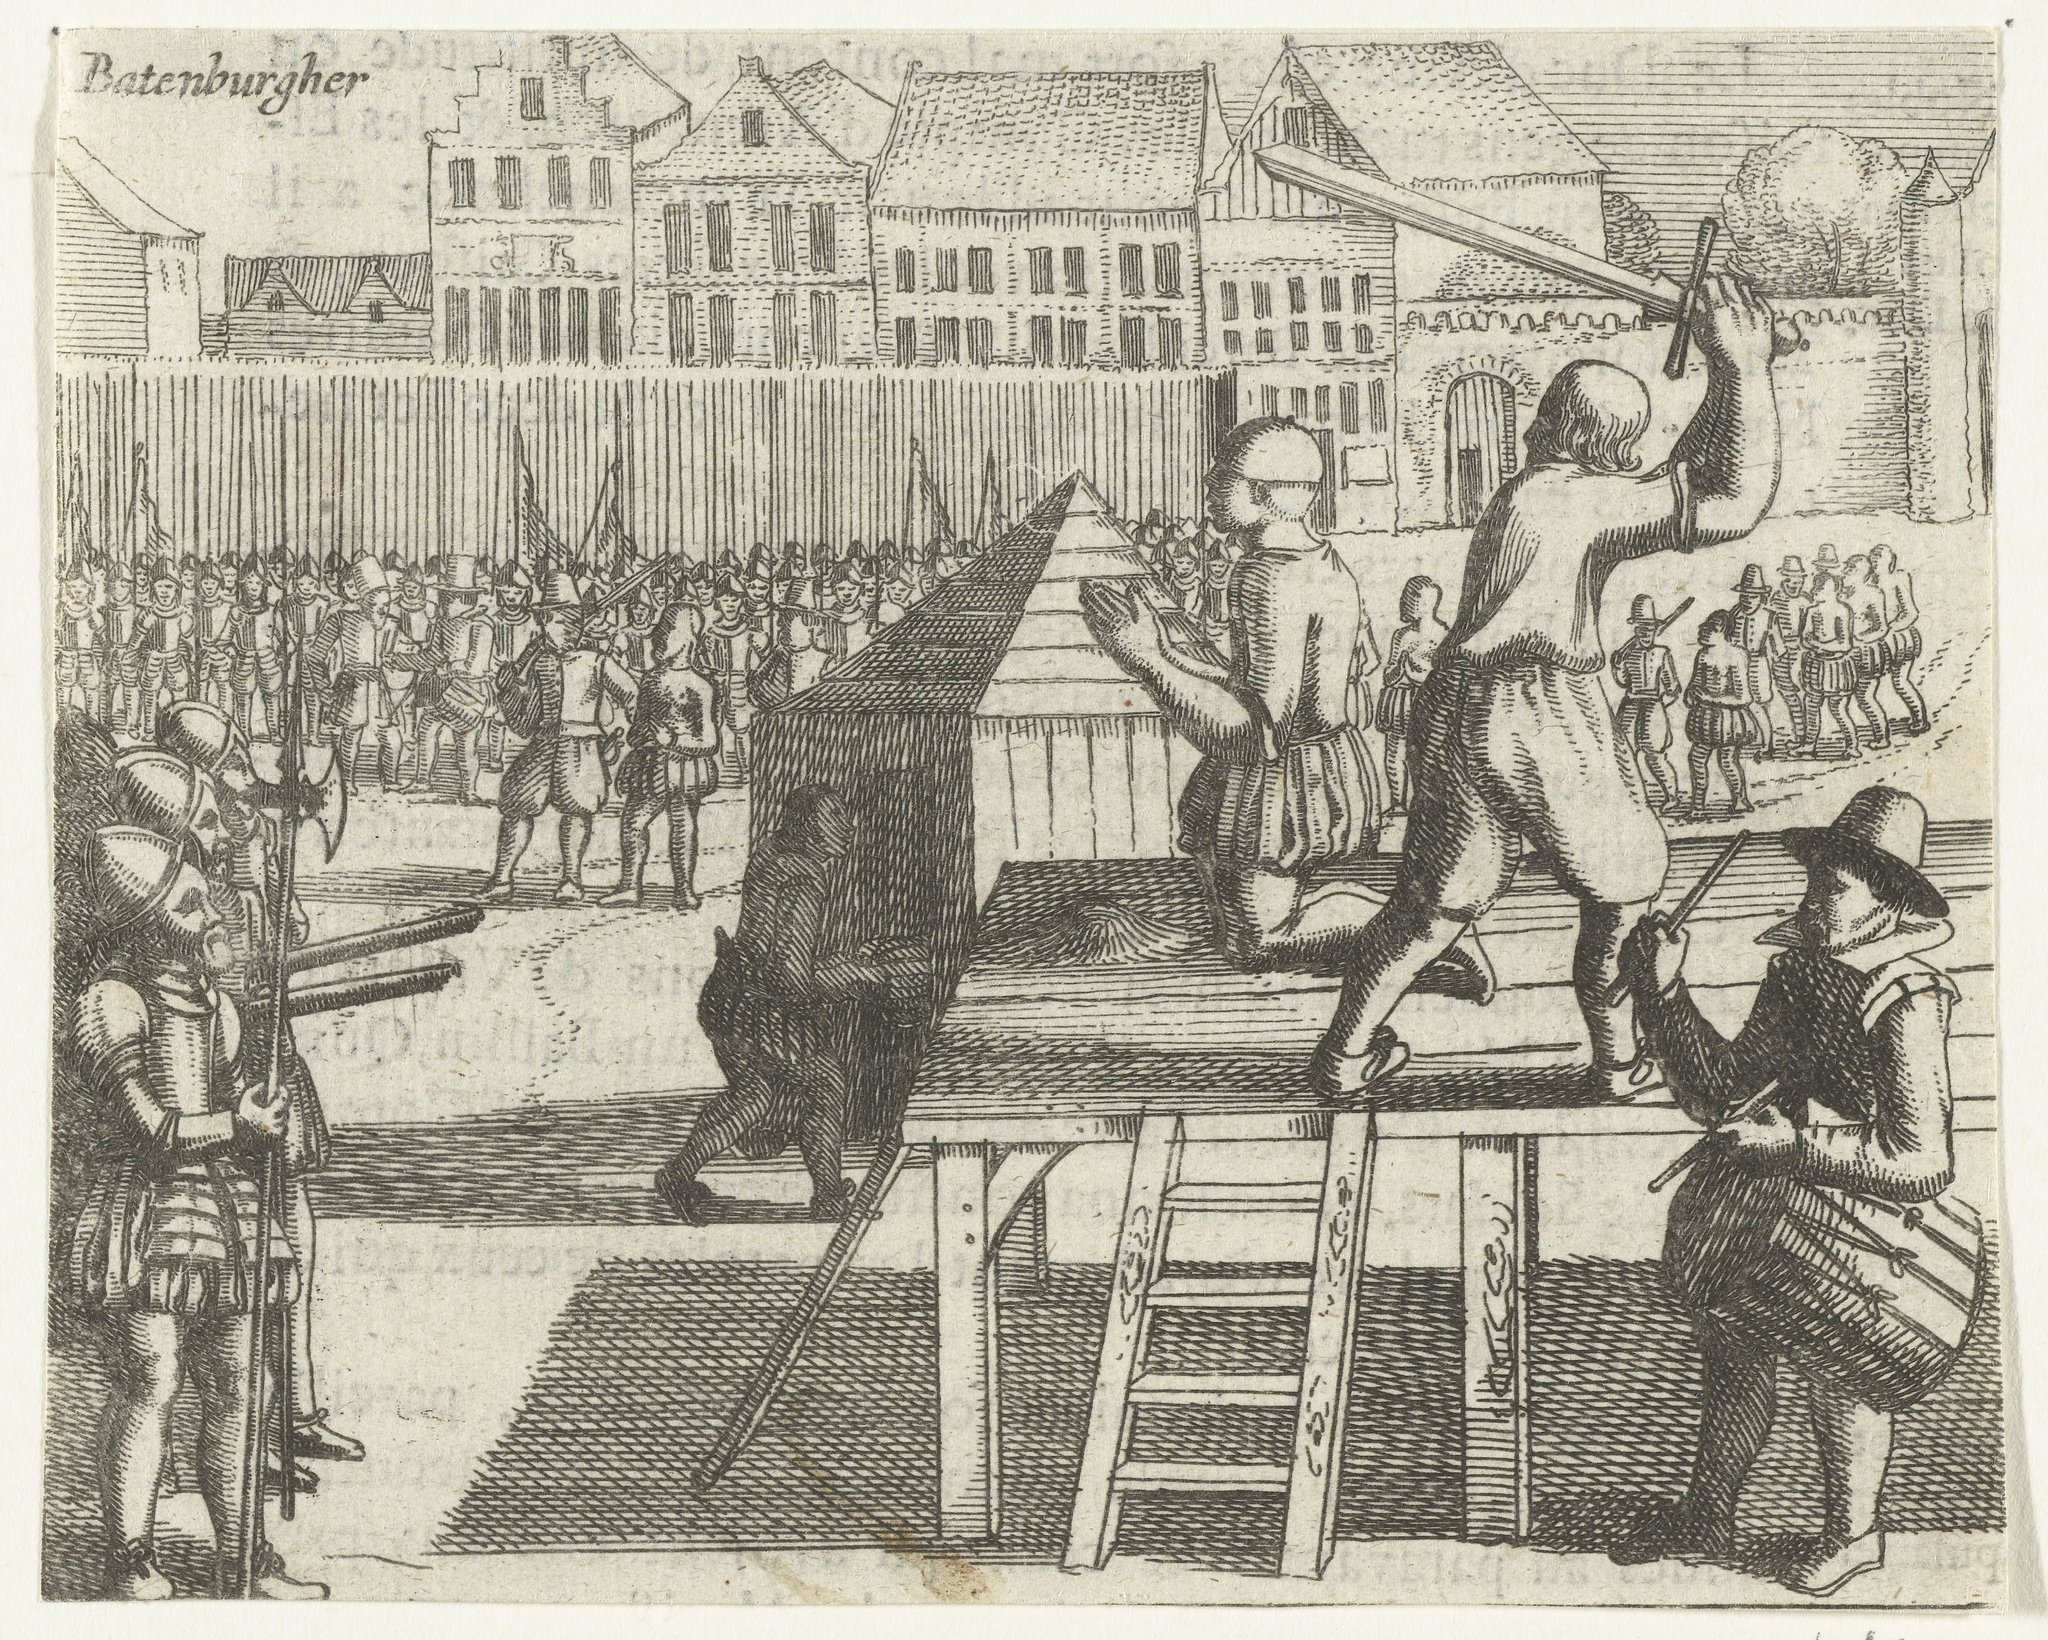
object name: history print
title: Onthoofding van achttien edelen, waaronder de twee gebroeders van Batenburg, 1568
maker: Anonymous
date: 1618-1620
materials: paper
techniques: etching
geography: low countries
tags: brussels, on the scaffold or place of execution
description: De onthoofding van achttien edelen, waaronder de twee gebroeders van Batenburg, op een schavot op de Paardenmarkt te Brussel, 1 juni 1568. De beul staat op het punt de veroordeelde te onthoofden. Bedrukt op achterzijde met tekst in het Frans.